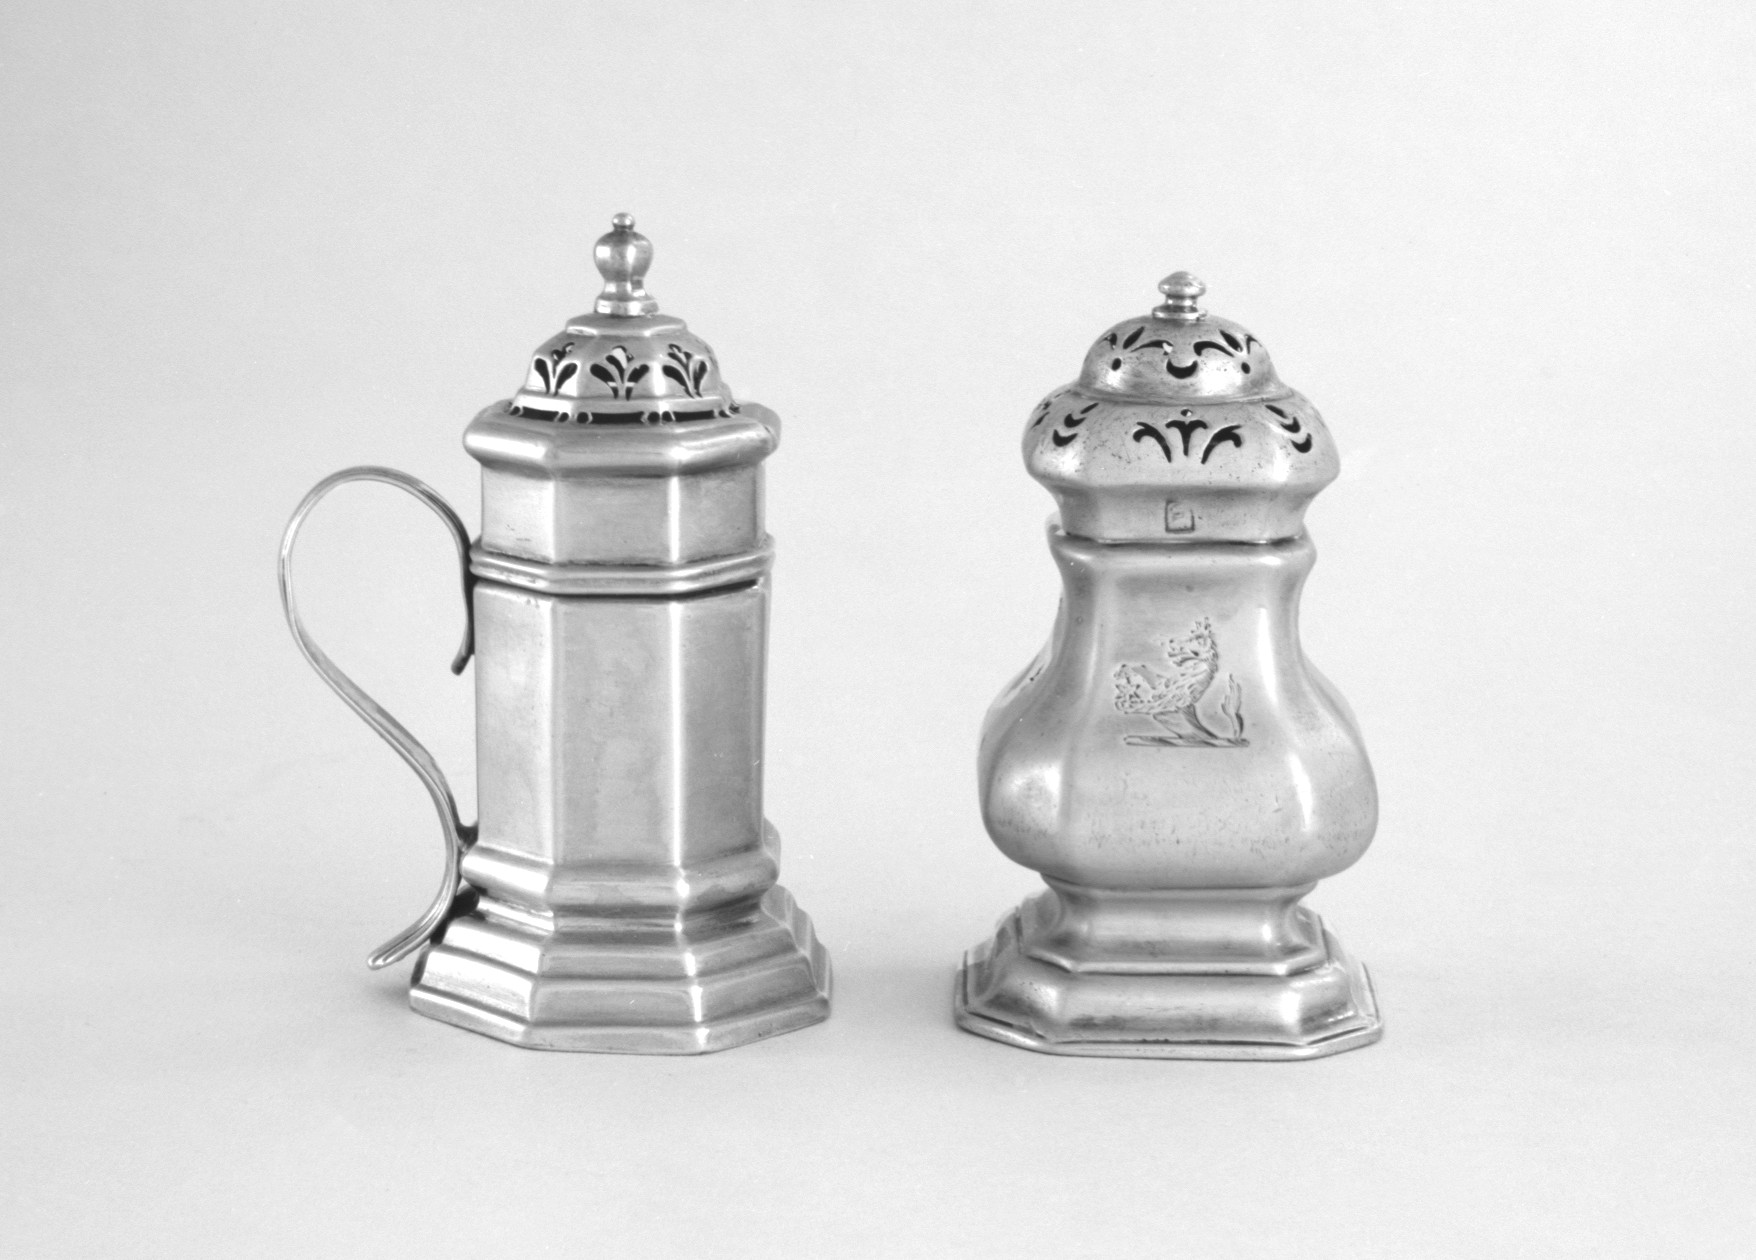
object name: dredger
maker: edward wood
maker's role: maker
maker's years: 1722-1752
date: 1722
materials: silver